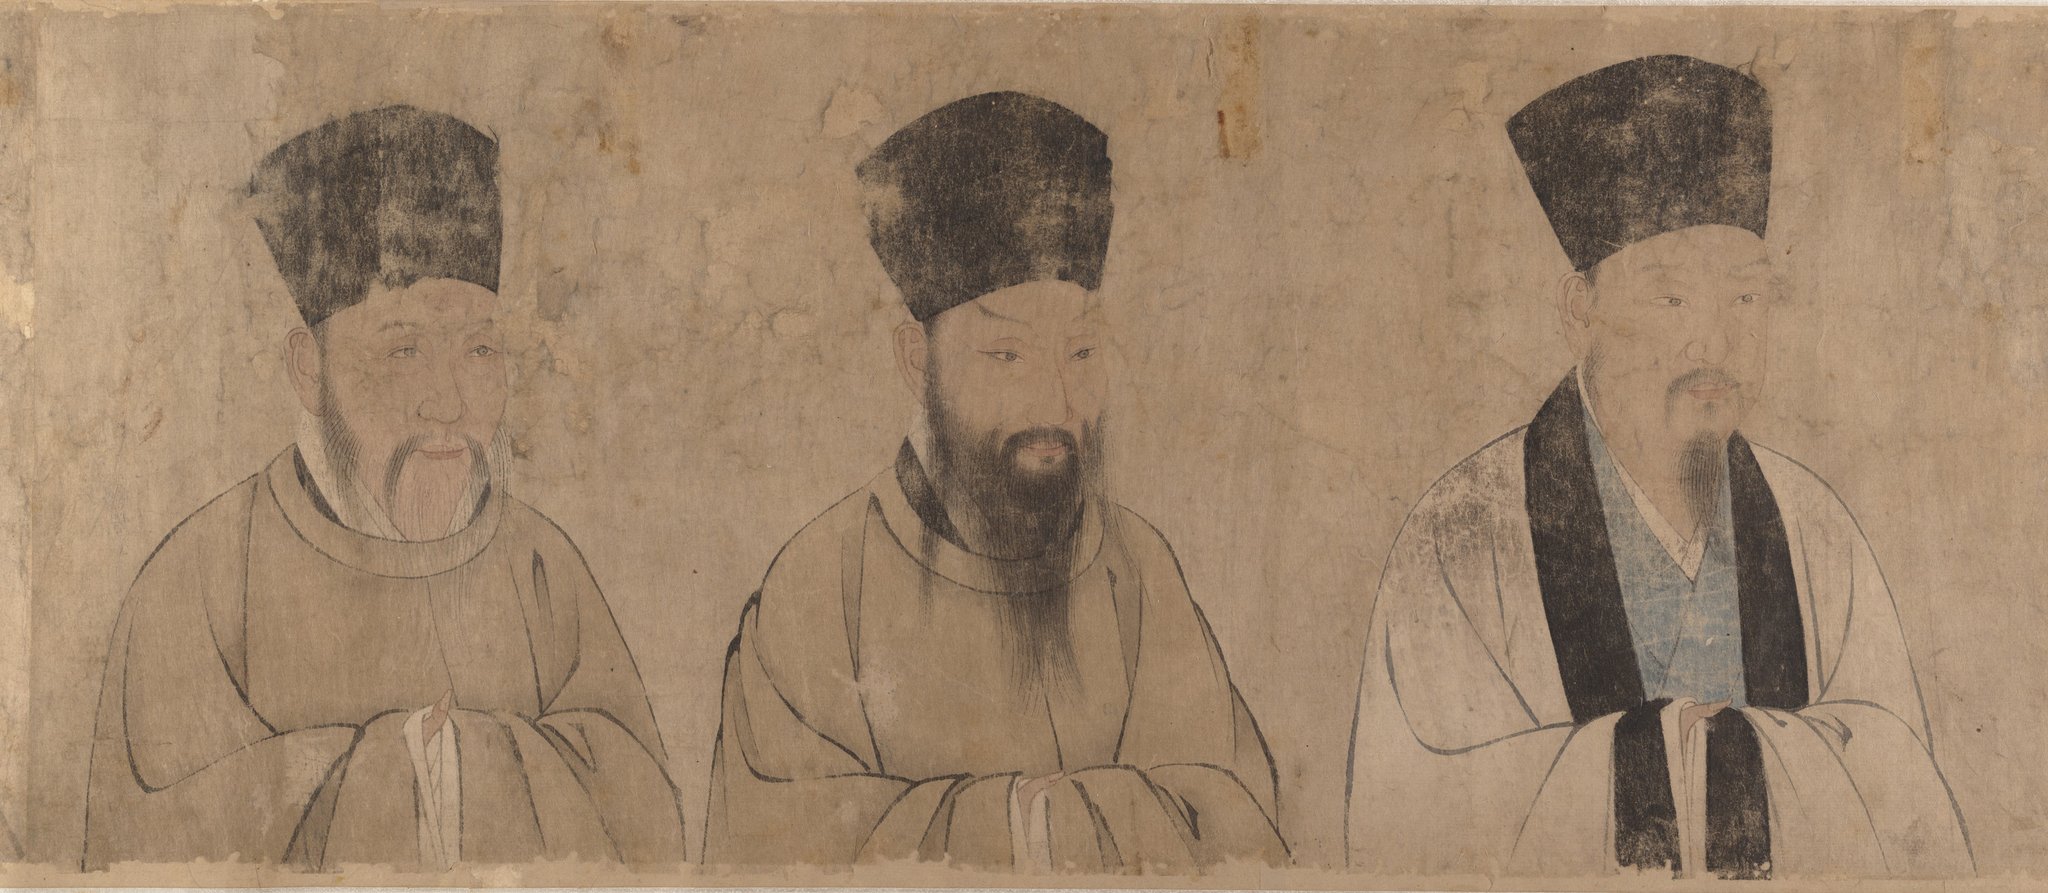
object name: handscroll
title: Twenty-five bust portraits of famous scholars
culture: chinese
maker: unidentified artist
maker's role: artist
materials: ink, paper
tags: men,portraits